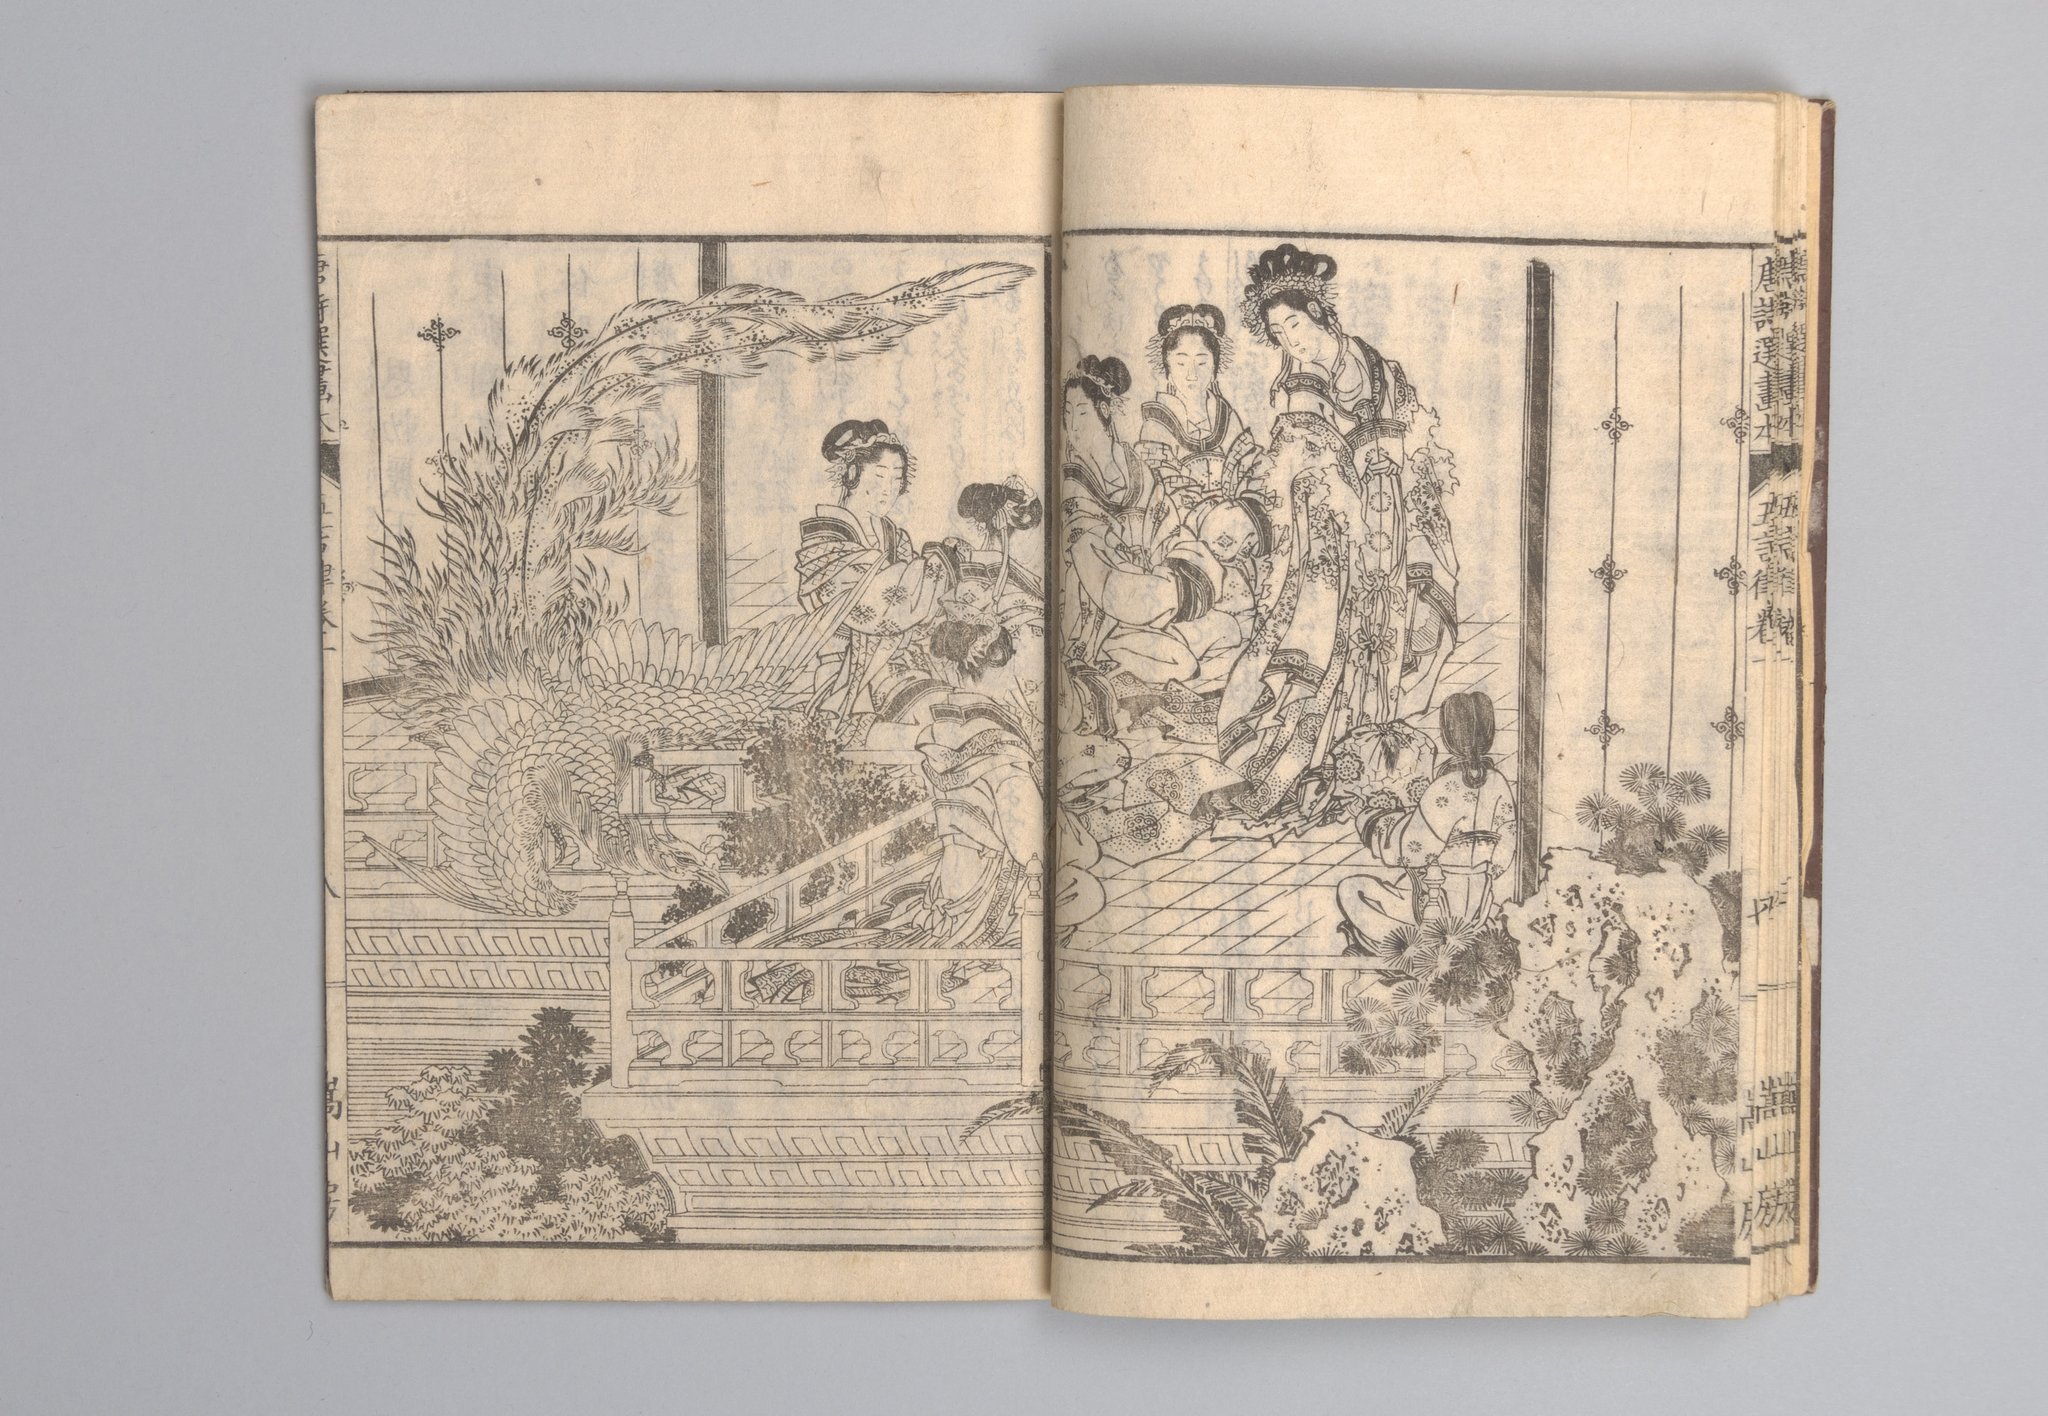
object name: illustrated book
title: Illustrated “Anthology of Tang-Dynasty Poems” in Five-Syllable Lines (Tōshisen ehon gogon ritsu hairitsu) 画本唐詩選五言律排律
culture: japanese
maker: katsushika hokusai 葛飾北斎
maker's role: artist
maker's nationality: japanese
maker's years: 1760-1849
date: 1836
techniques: bookbinding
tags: women,mythical creatures,plants